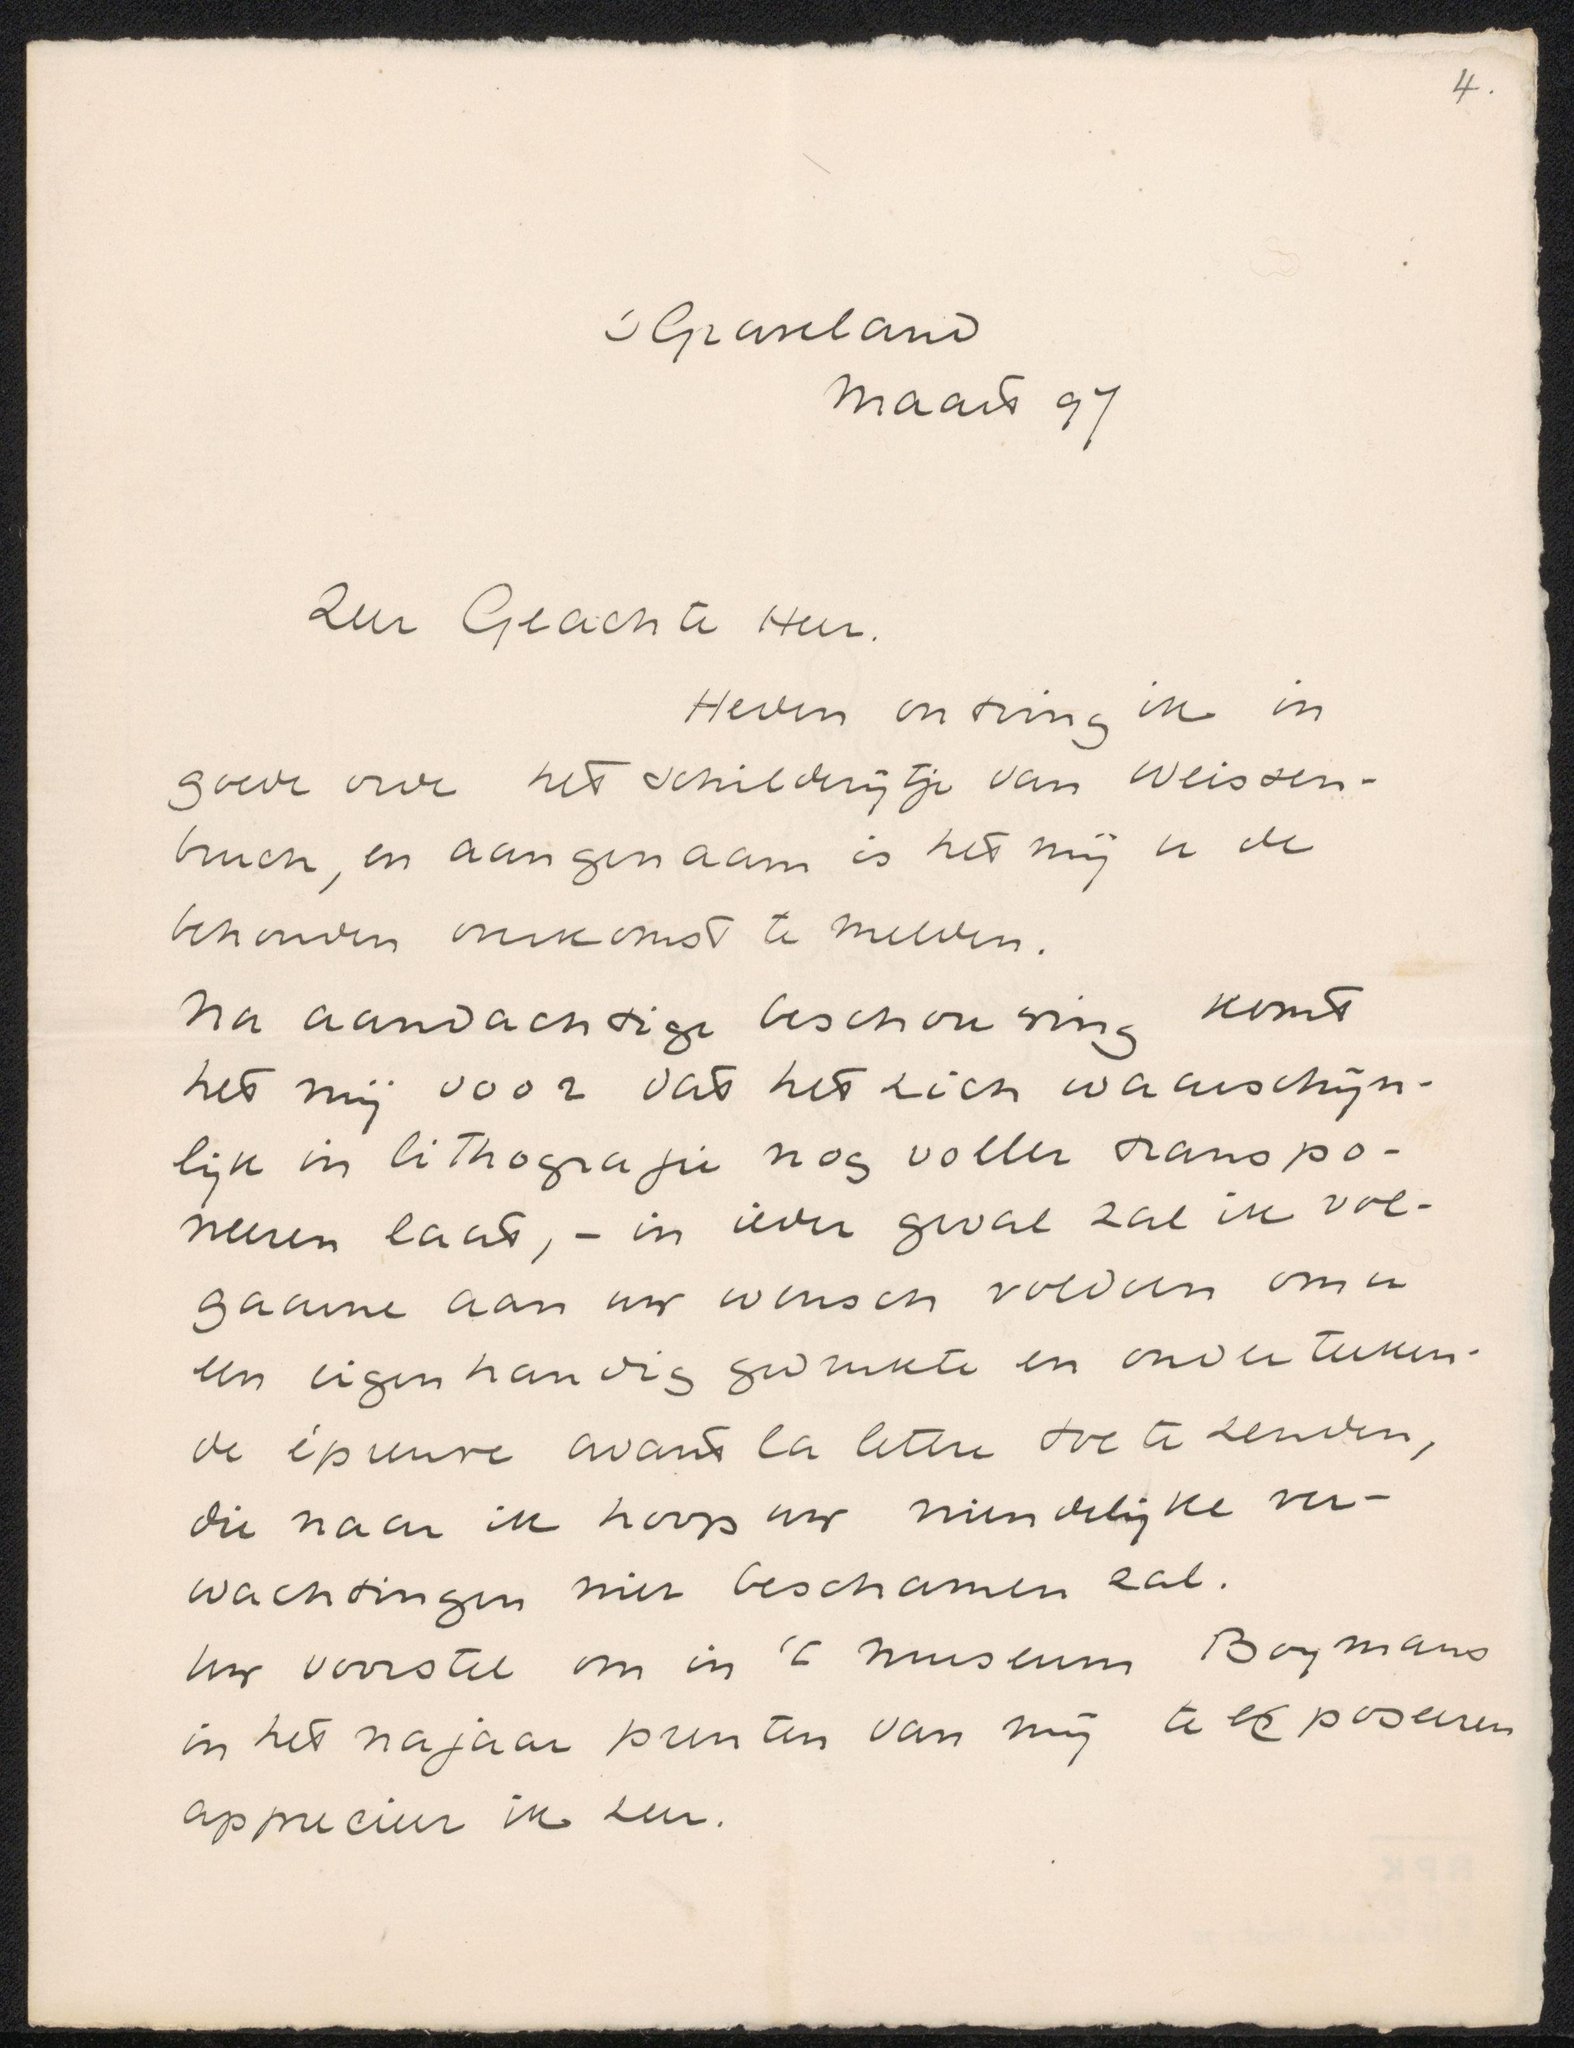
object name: letter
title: Brief aan Pieter Haverkorn van Rijsewijk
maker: richard nicolaüs roland holst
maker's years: 1868-1938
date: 1803-1897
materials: ink, paper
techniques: pen, writing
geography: s-graveland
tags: the hague, painter, print maker, draughtsman, johan hendrik weissenbruch, pieter haverkorn van rijsewijk, the graphic arts, painting (including book-illumination, miniature-painting), exhibition ~ art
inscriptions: watermark, collector's mark: ‘RPK’